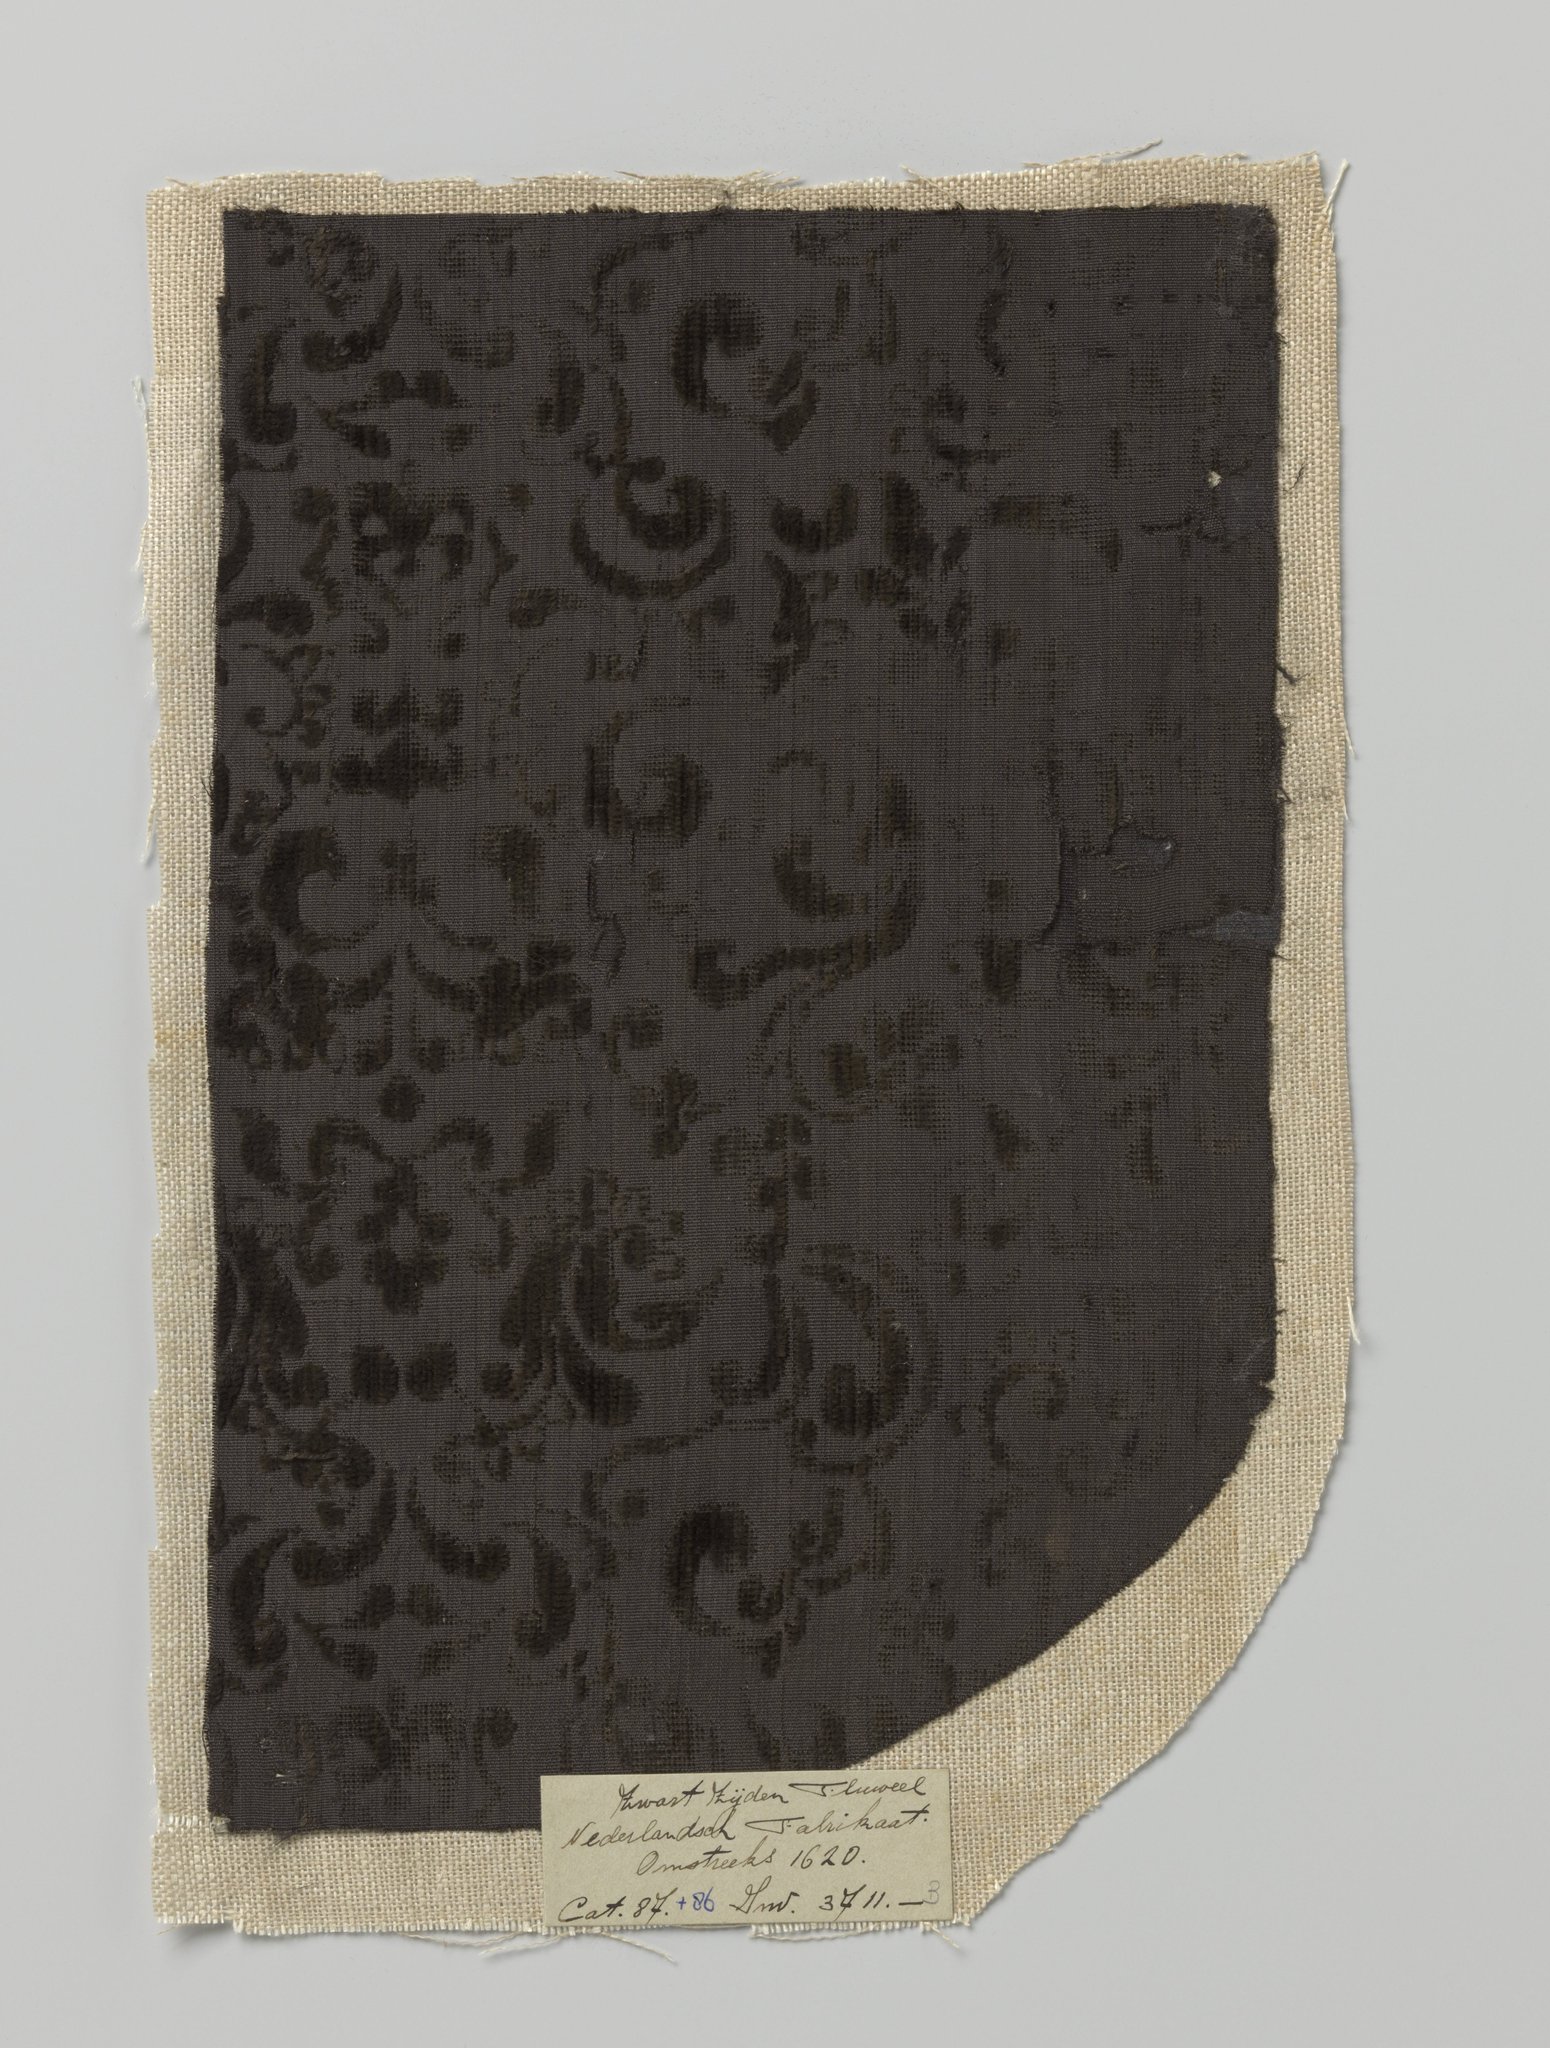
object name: fragment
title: Fragment reliëffluweel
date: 1600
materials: silk, velvet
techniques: weave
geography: netherlands